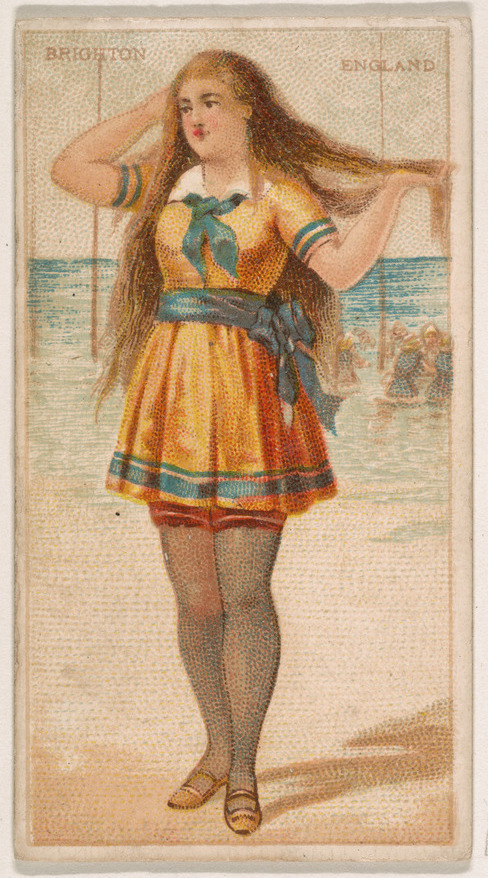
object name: print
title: Brighton, England, from the Surf Beauties series (N232), issued by Kinney Bros.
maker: kinney brothers tobacco company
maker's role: publisher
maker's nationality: american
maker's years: 1869-2011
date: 1889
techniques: color lithograph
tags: women,sports